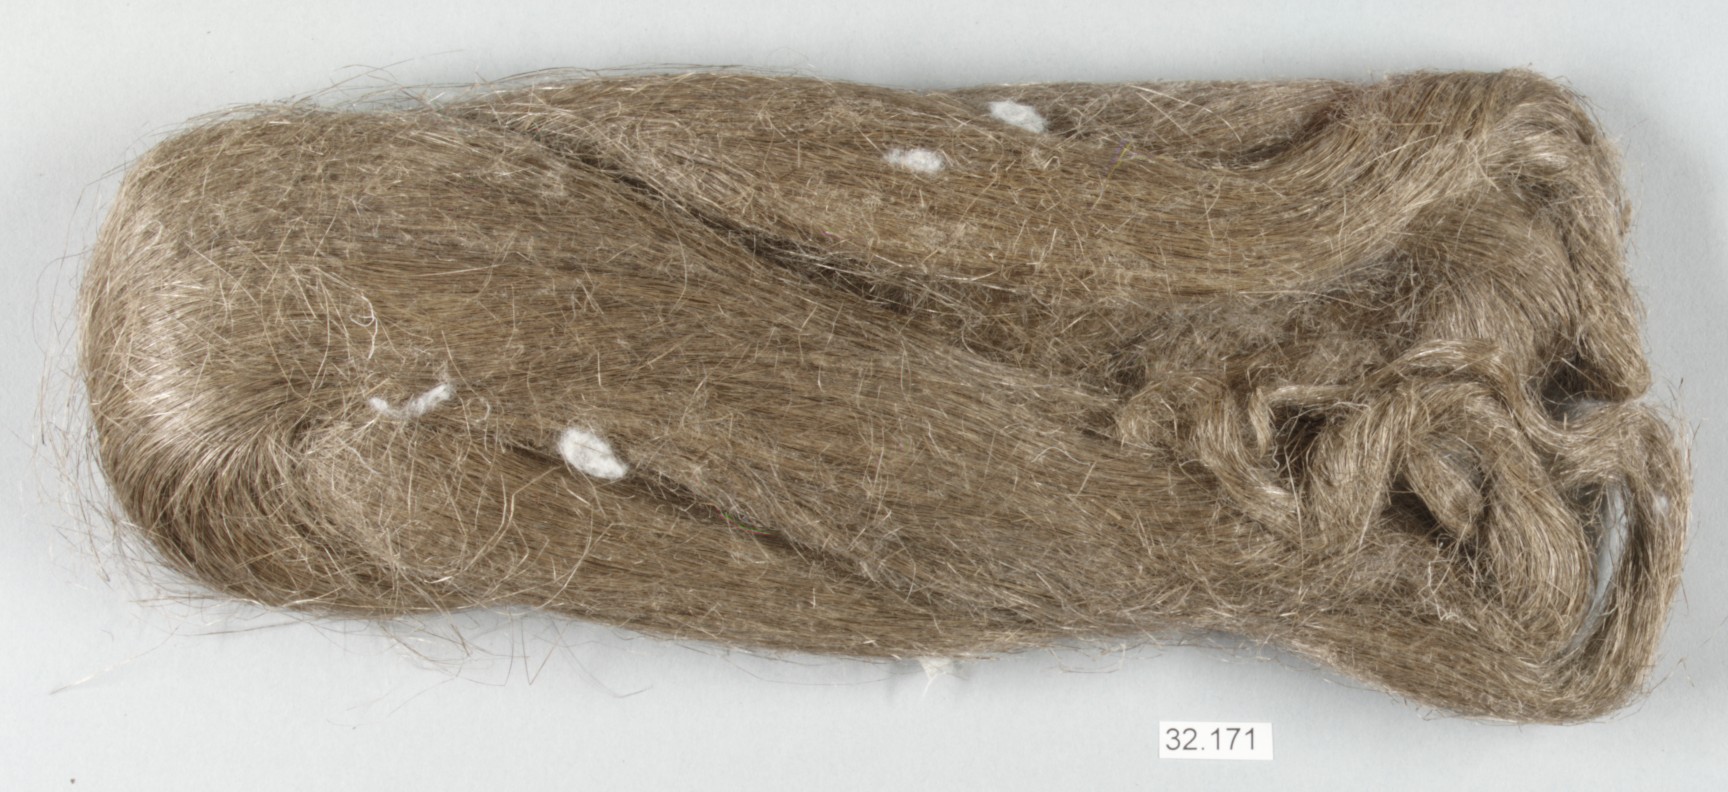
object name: flax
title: Flax (Hank)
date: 1801-1833